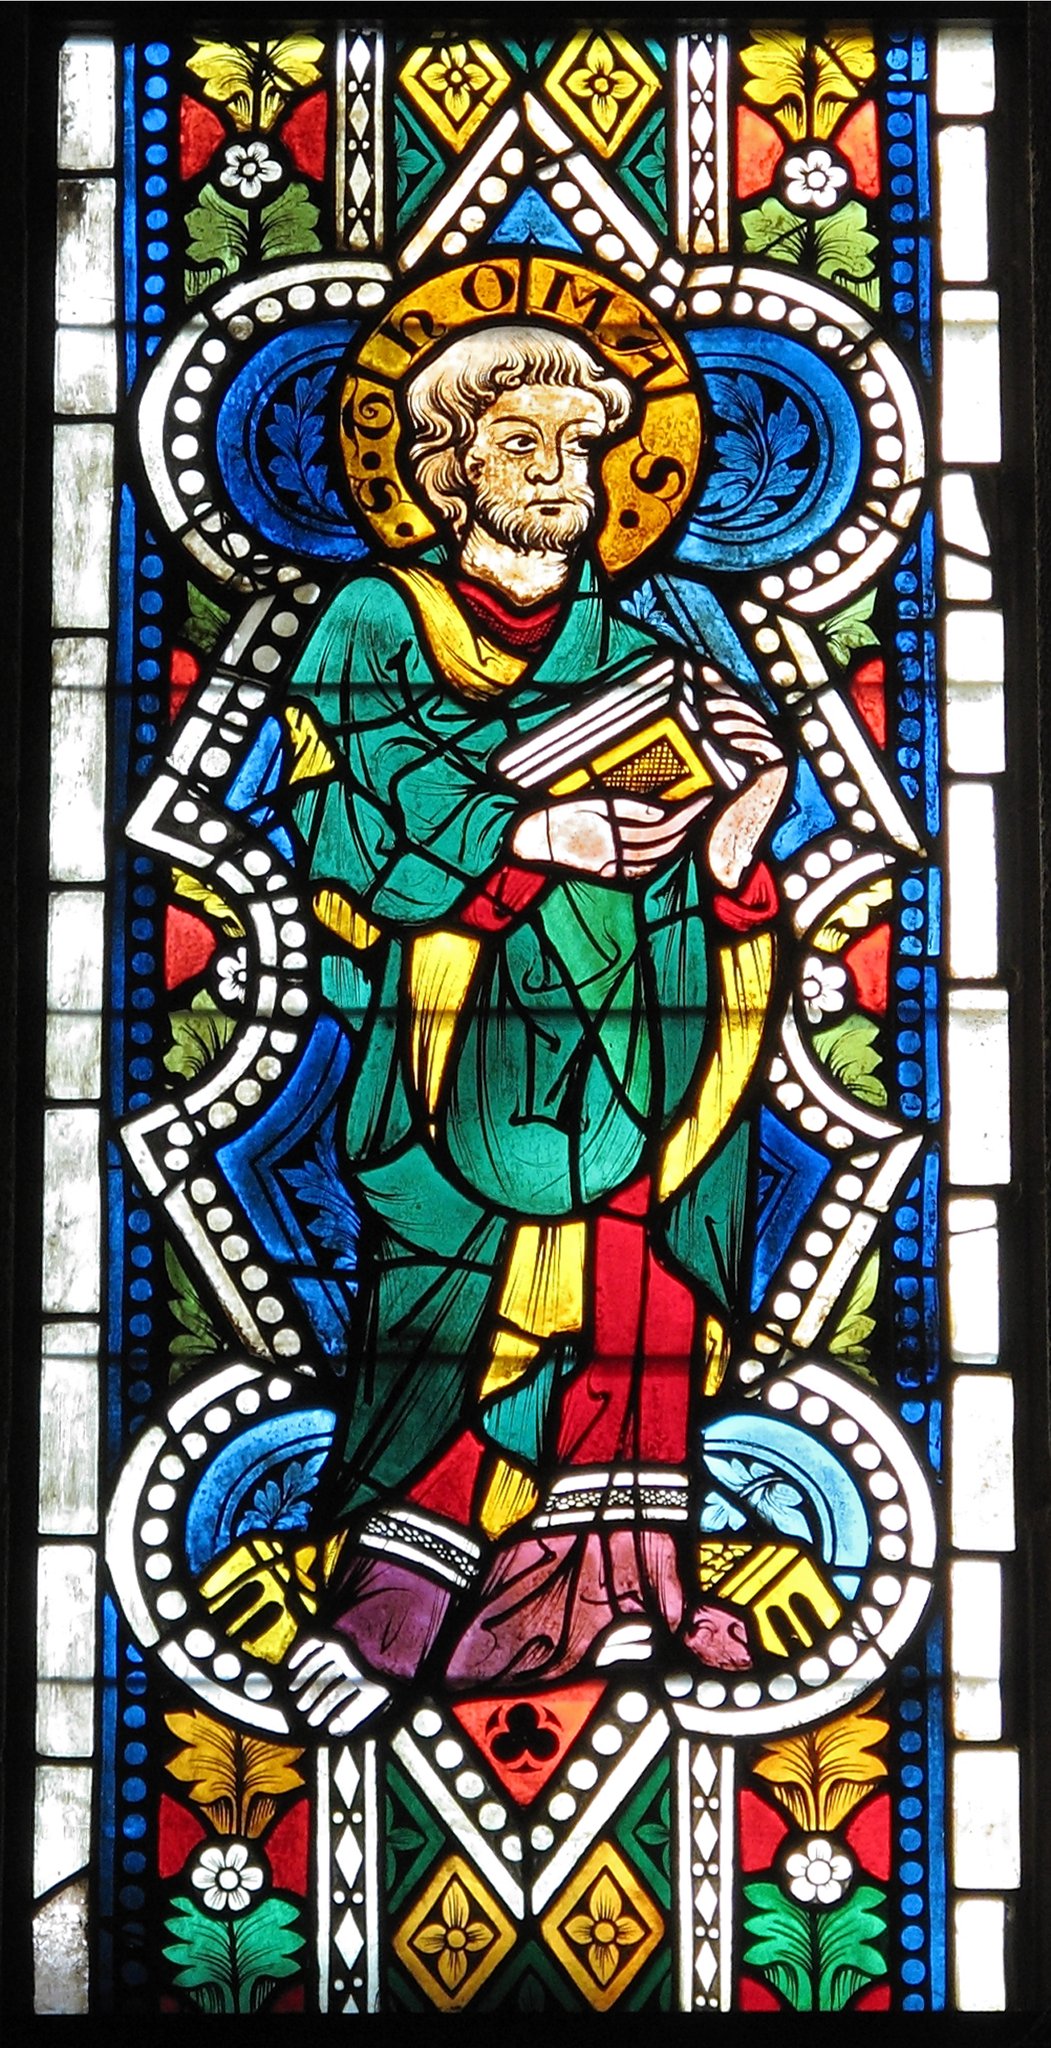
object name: panel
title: Saint Thomas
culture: austrian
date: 1340-1350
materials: glass, metal, paint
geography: austria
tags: men,saints